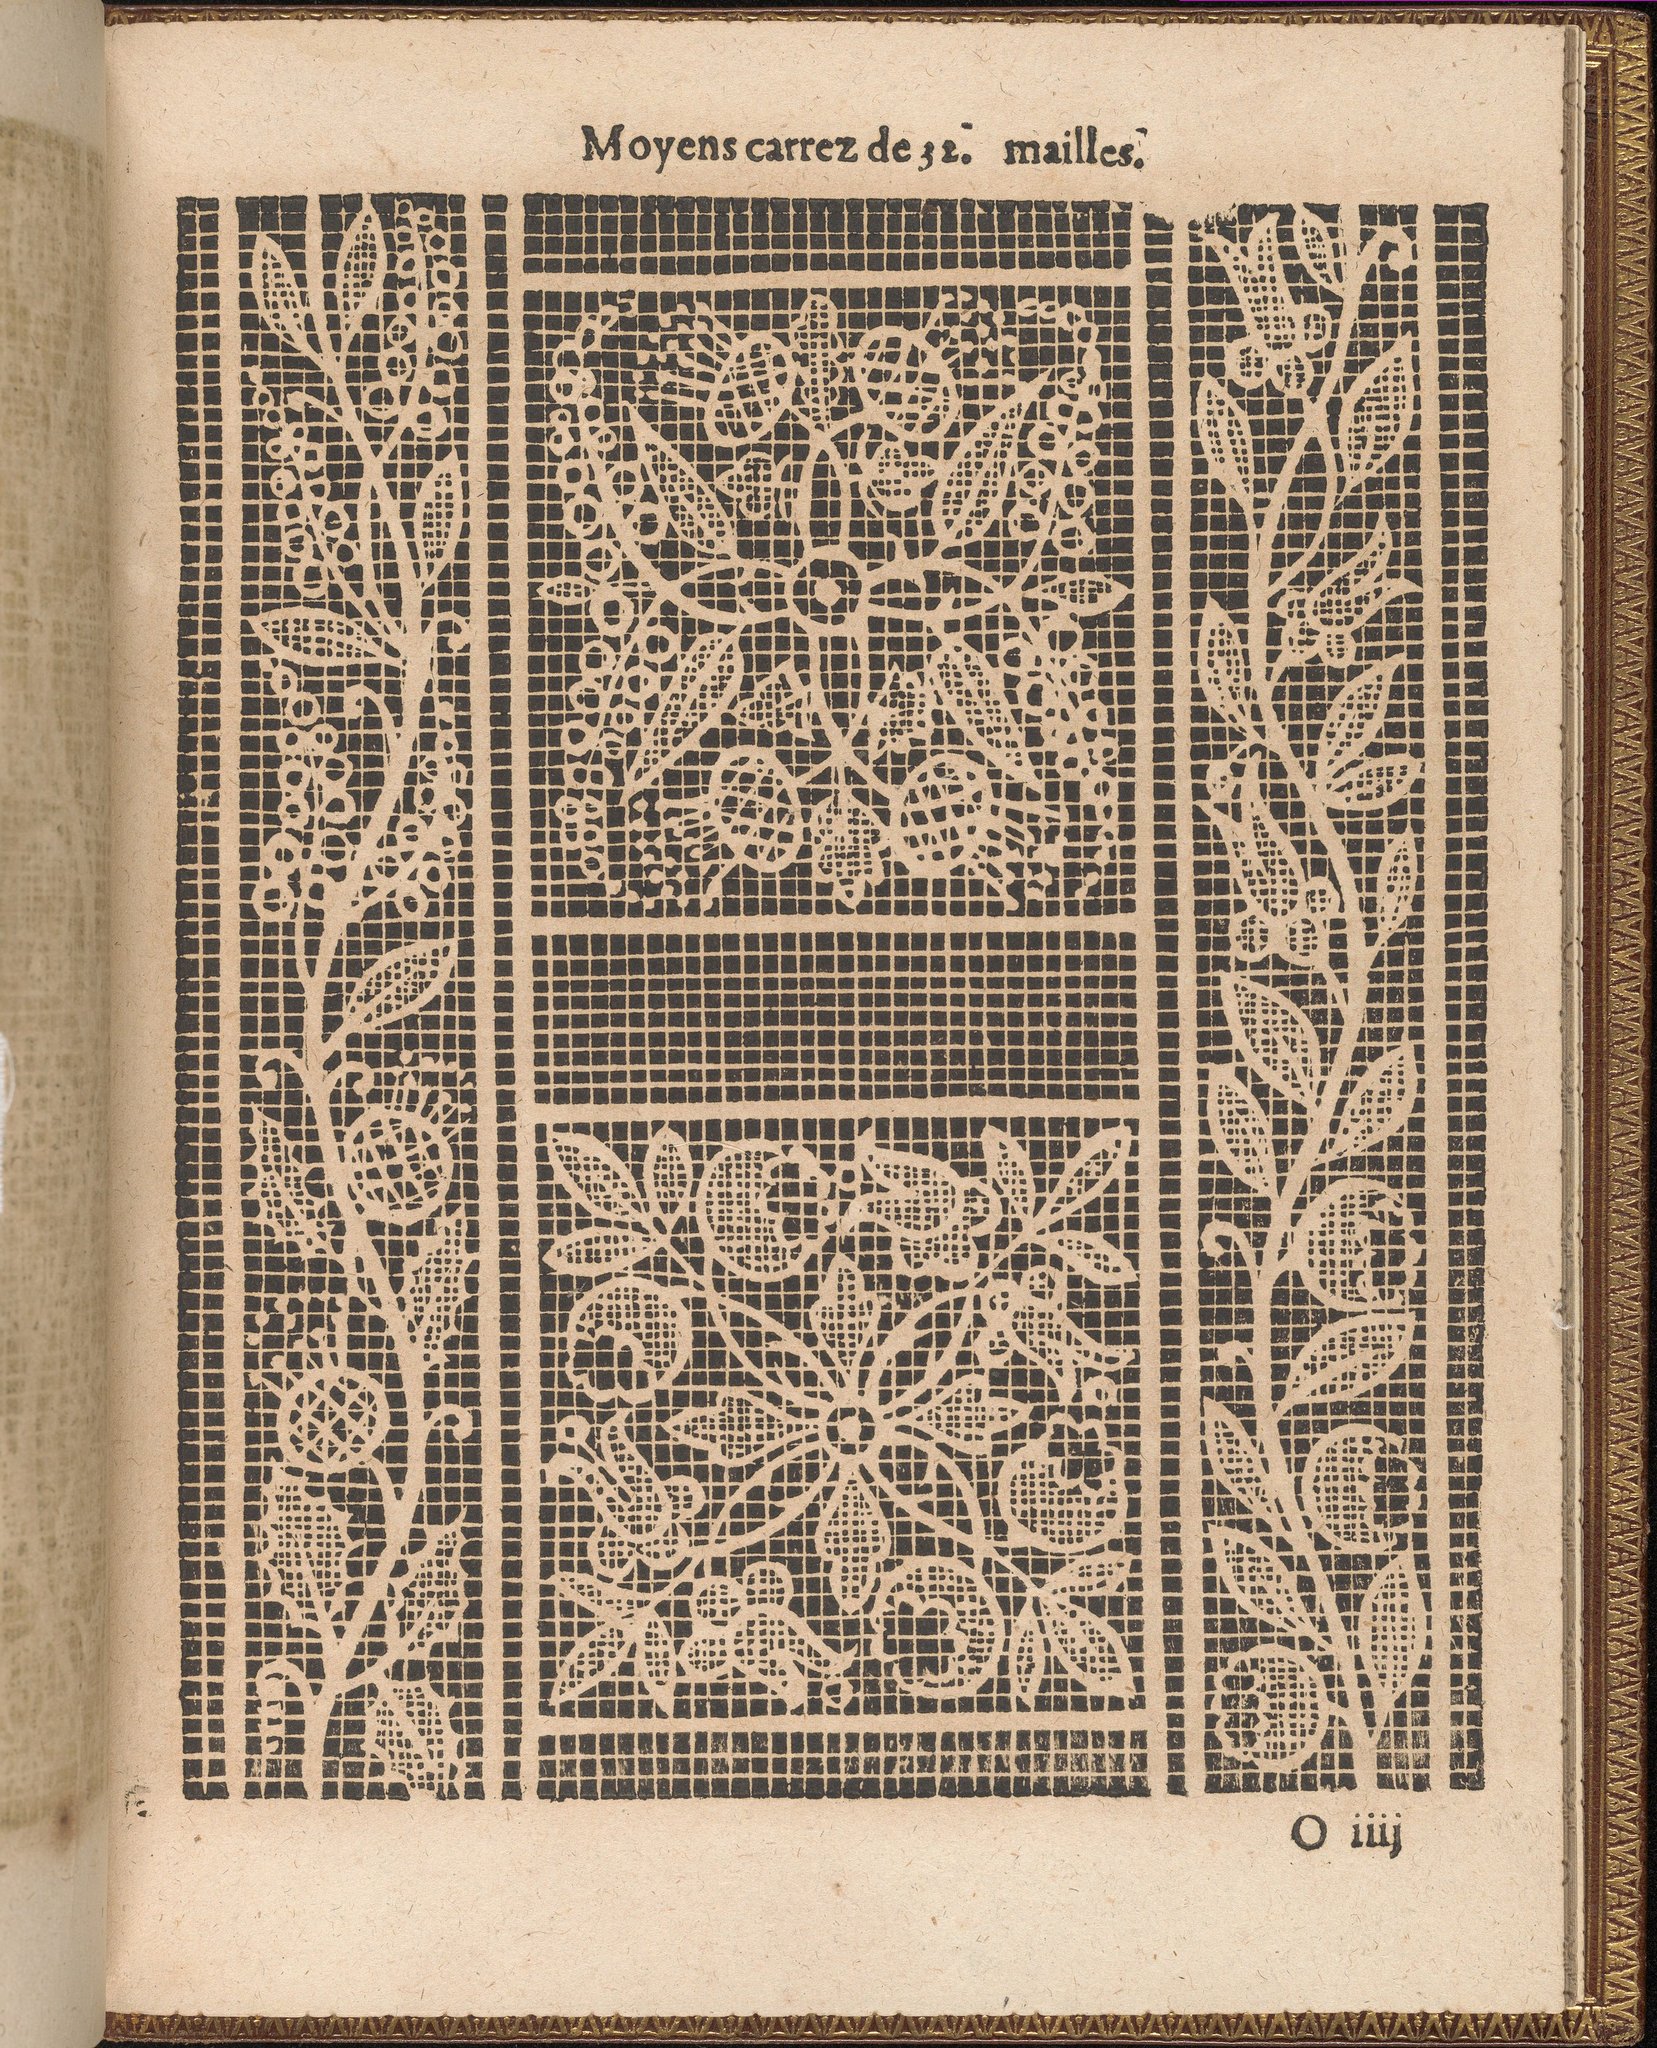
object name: book print ornament architecture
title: La Pratique de l'Aiguille, page 55 (recto)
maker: matthias mignerak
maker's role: author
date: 1605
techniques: woodcut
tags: ornament